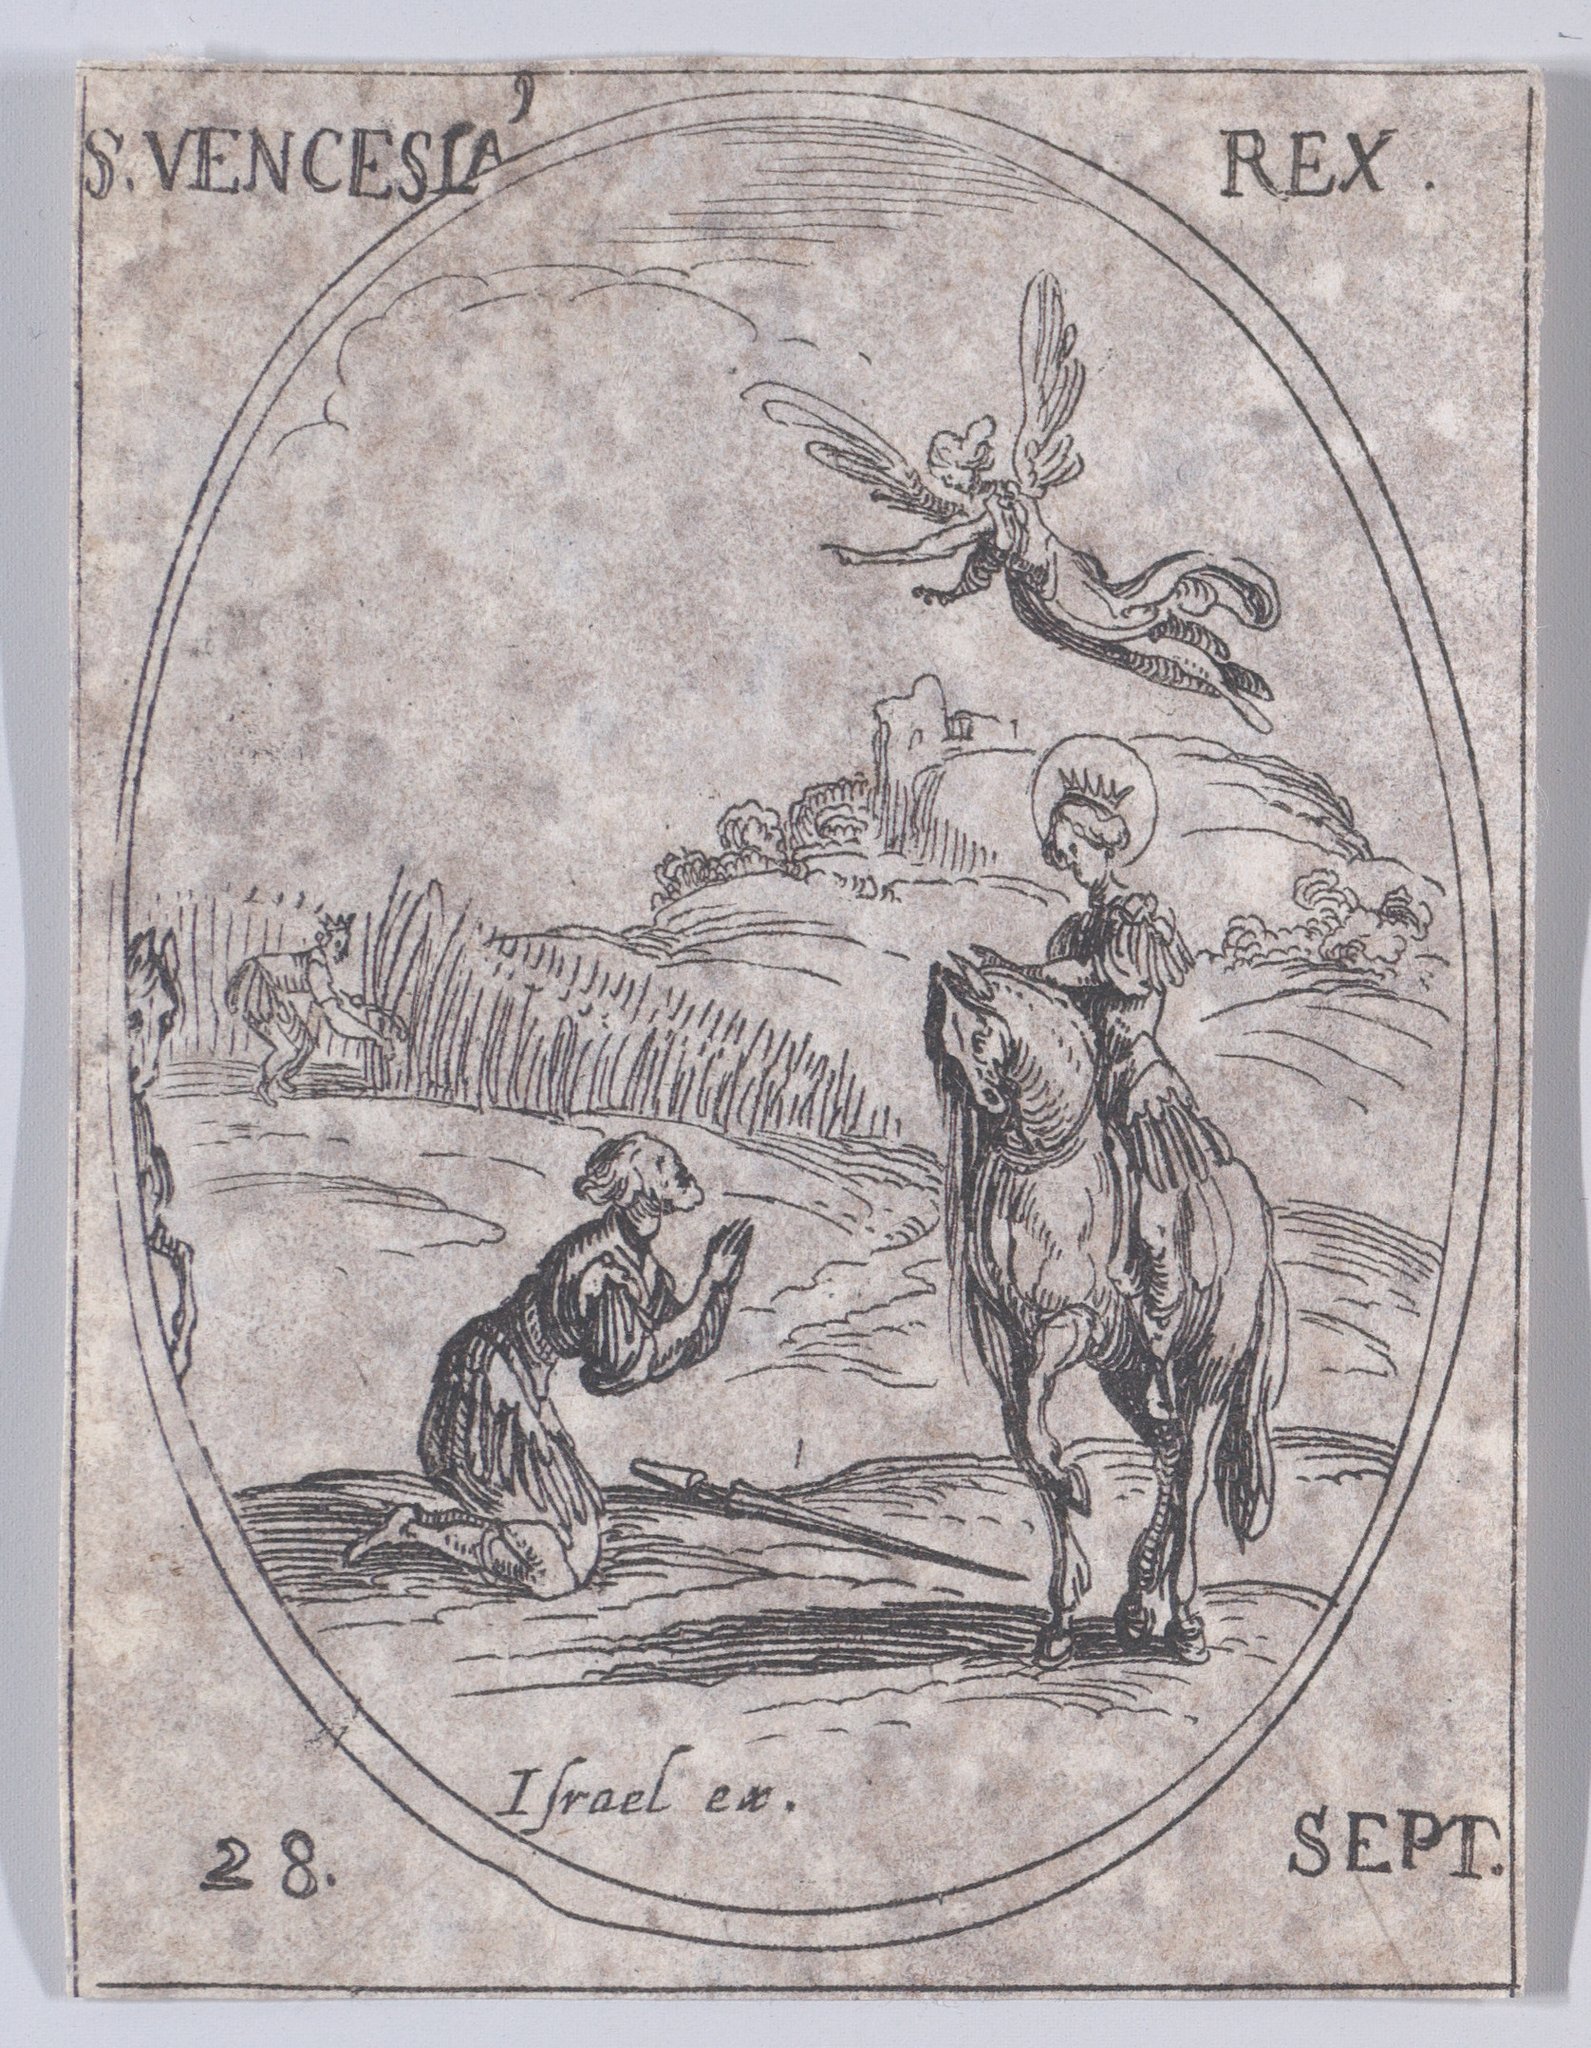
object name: print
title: S. Wenceslas, roi (St. Wenceslaus, King), September 28th, from "Les Images De Tous Les Saincts et Saintes de L'Année" (Images of All of the Saints and Religious Events of the Year)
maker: jacques callot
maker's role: artist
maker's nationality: french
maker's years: 1592-1635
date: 1636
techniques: etching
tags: kings,men,horses,angels,saints